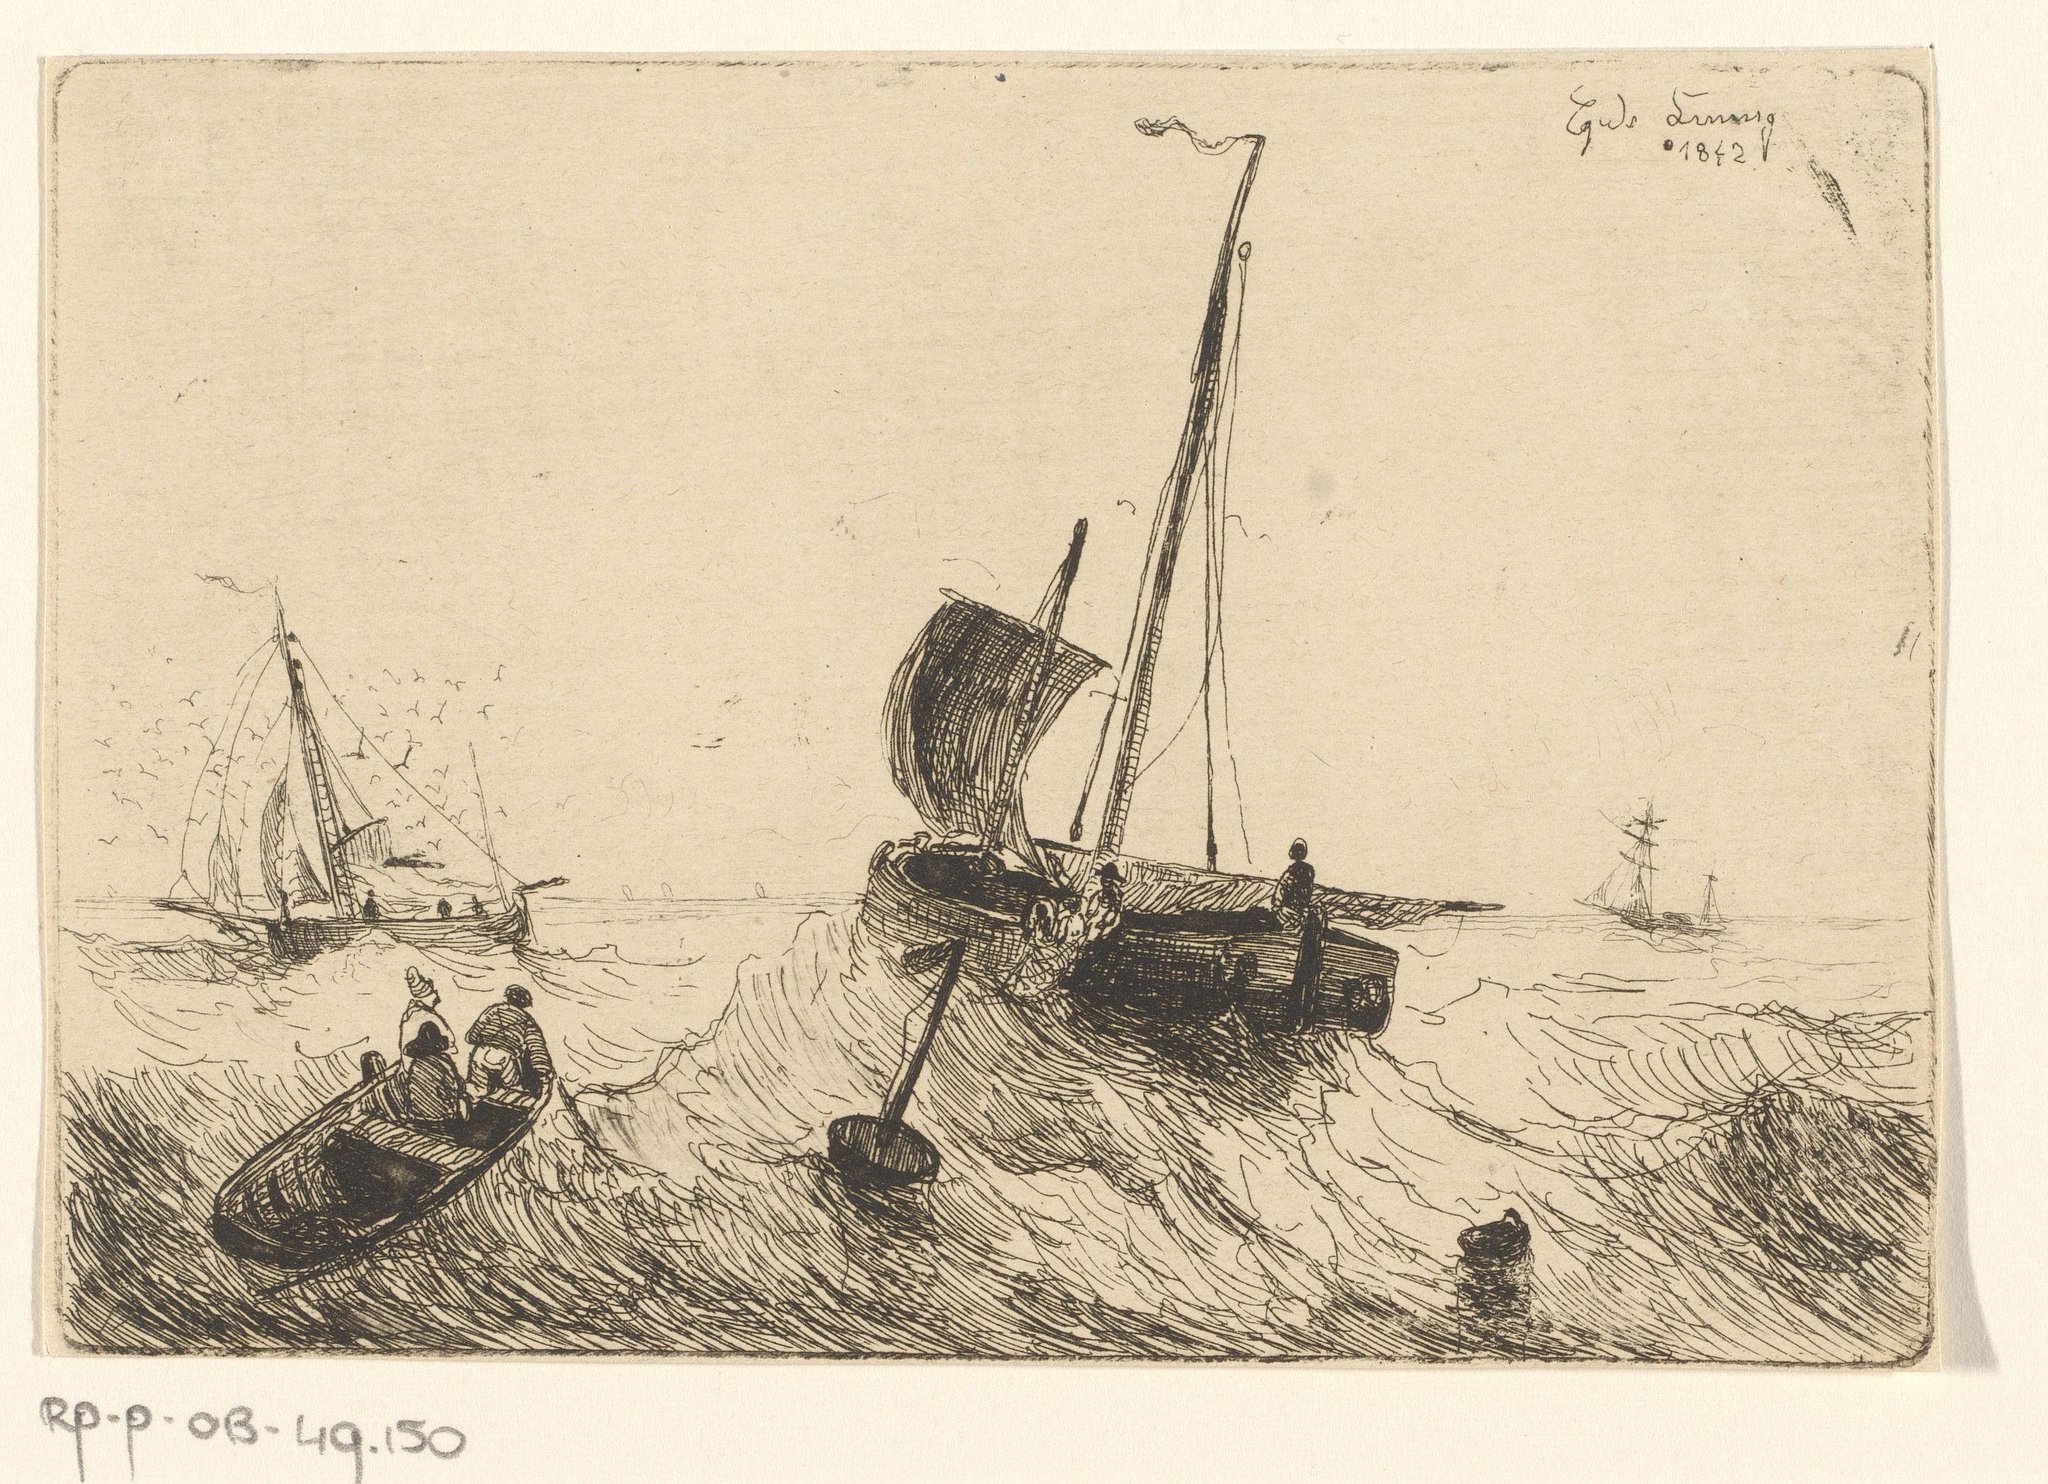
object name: print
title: Vertrek van een vissersboot uit Blankenberge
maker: egidius linnig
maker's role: draughtsman, print maker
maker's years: 1821-1860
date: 1842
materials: paper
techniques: etching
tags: sailing-ship, sailing-boat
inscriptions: date